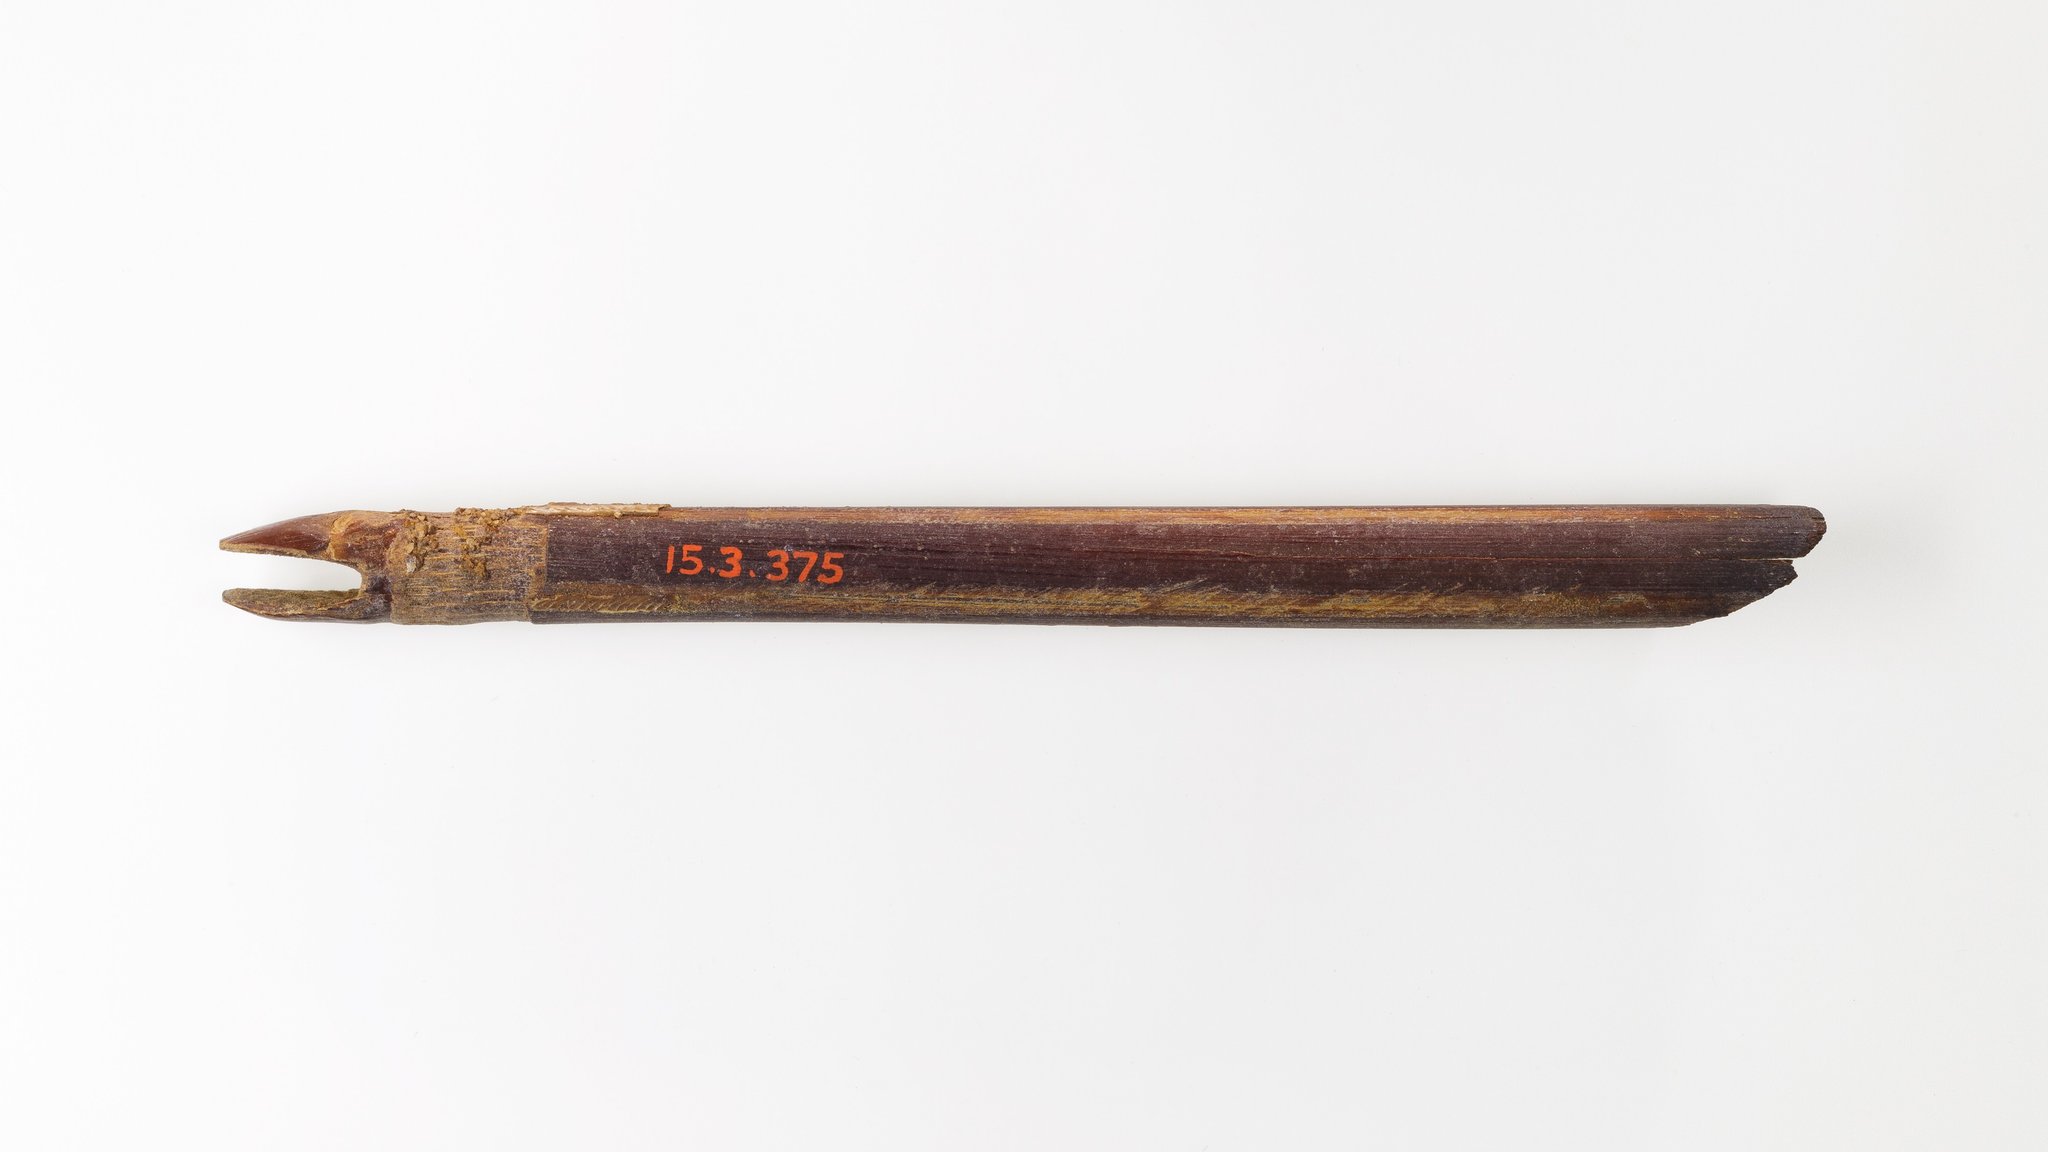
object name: arrow fragment, butt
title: Arrow fragment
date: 1981-1640 BCE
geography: egypt